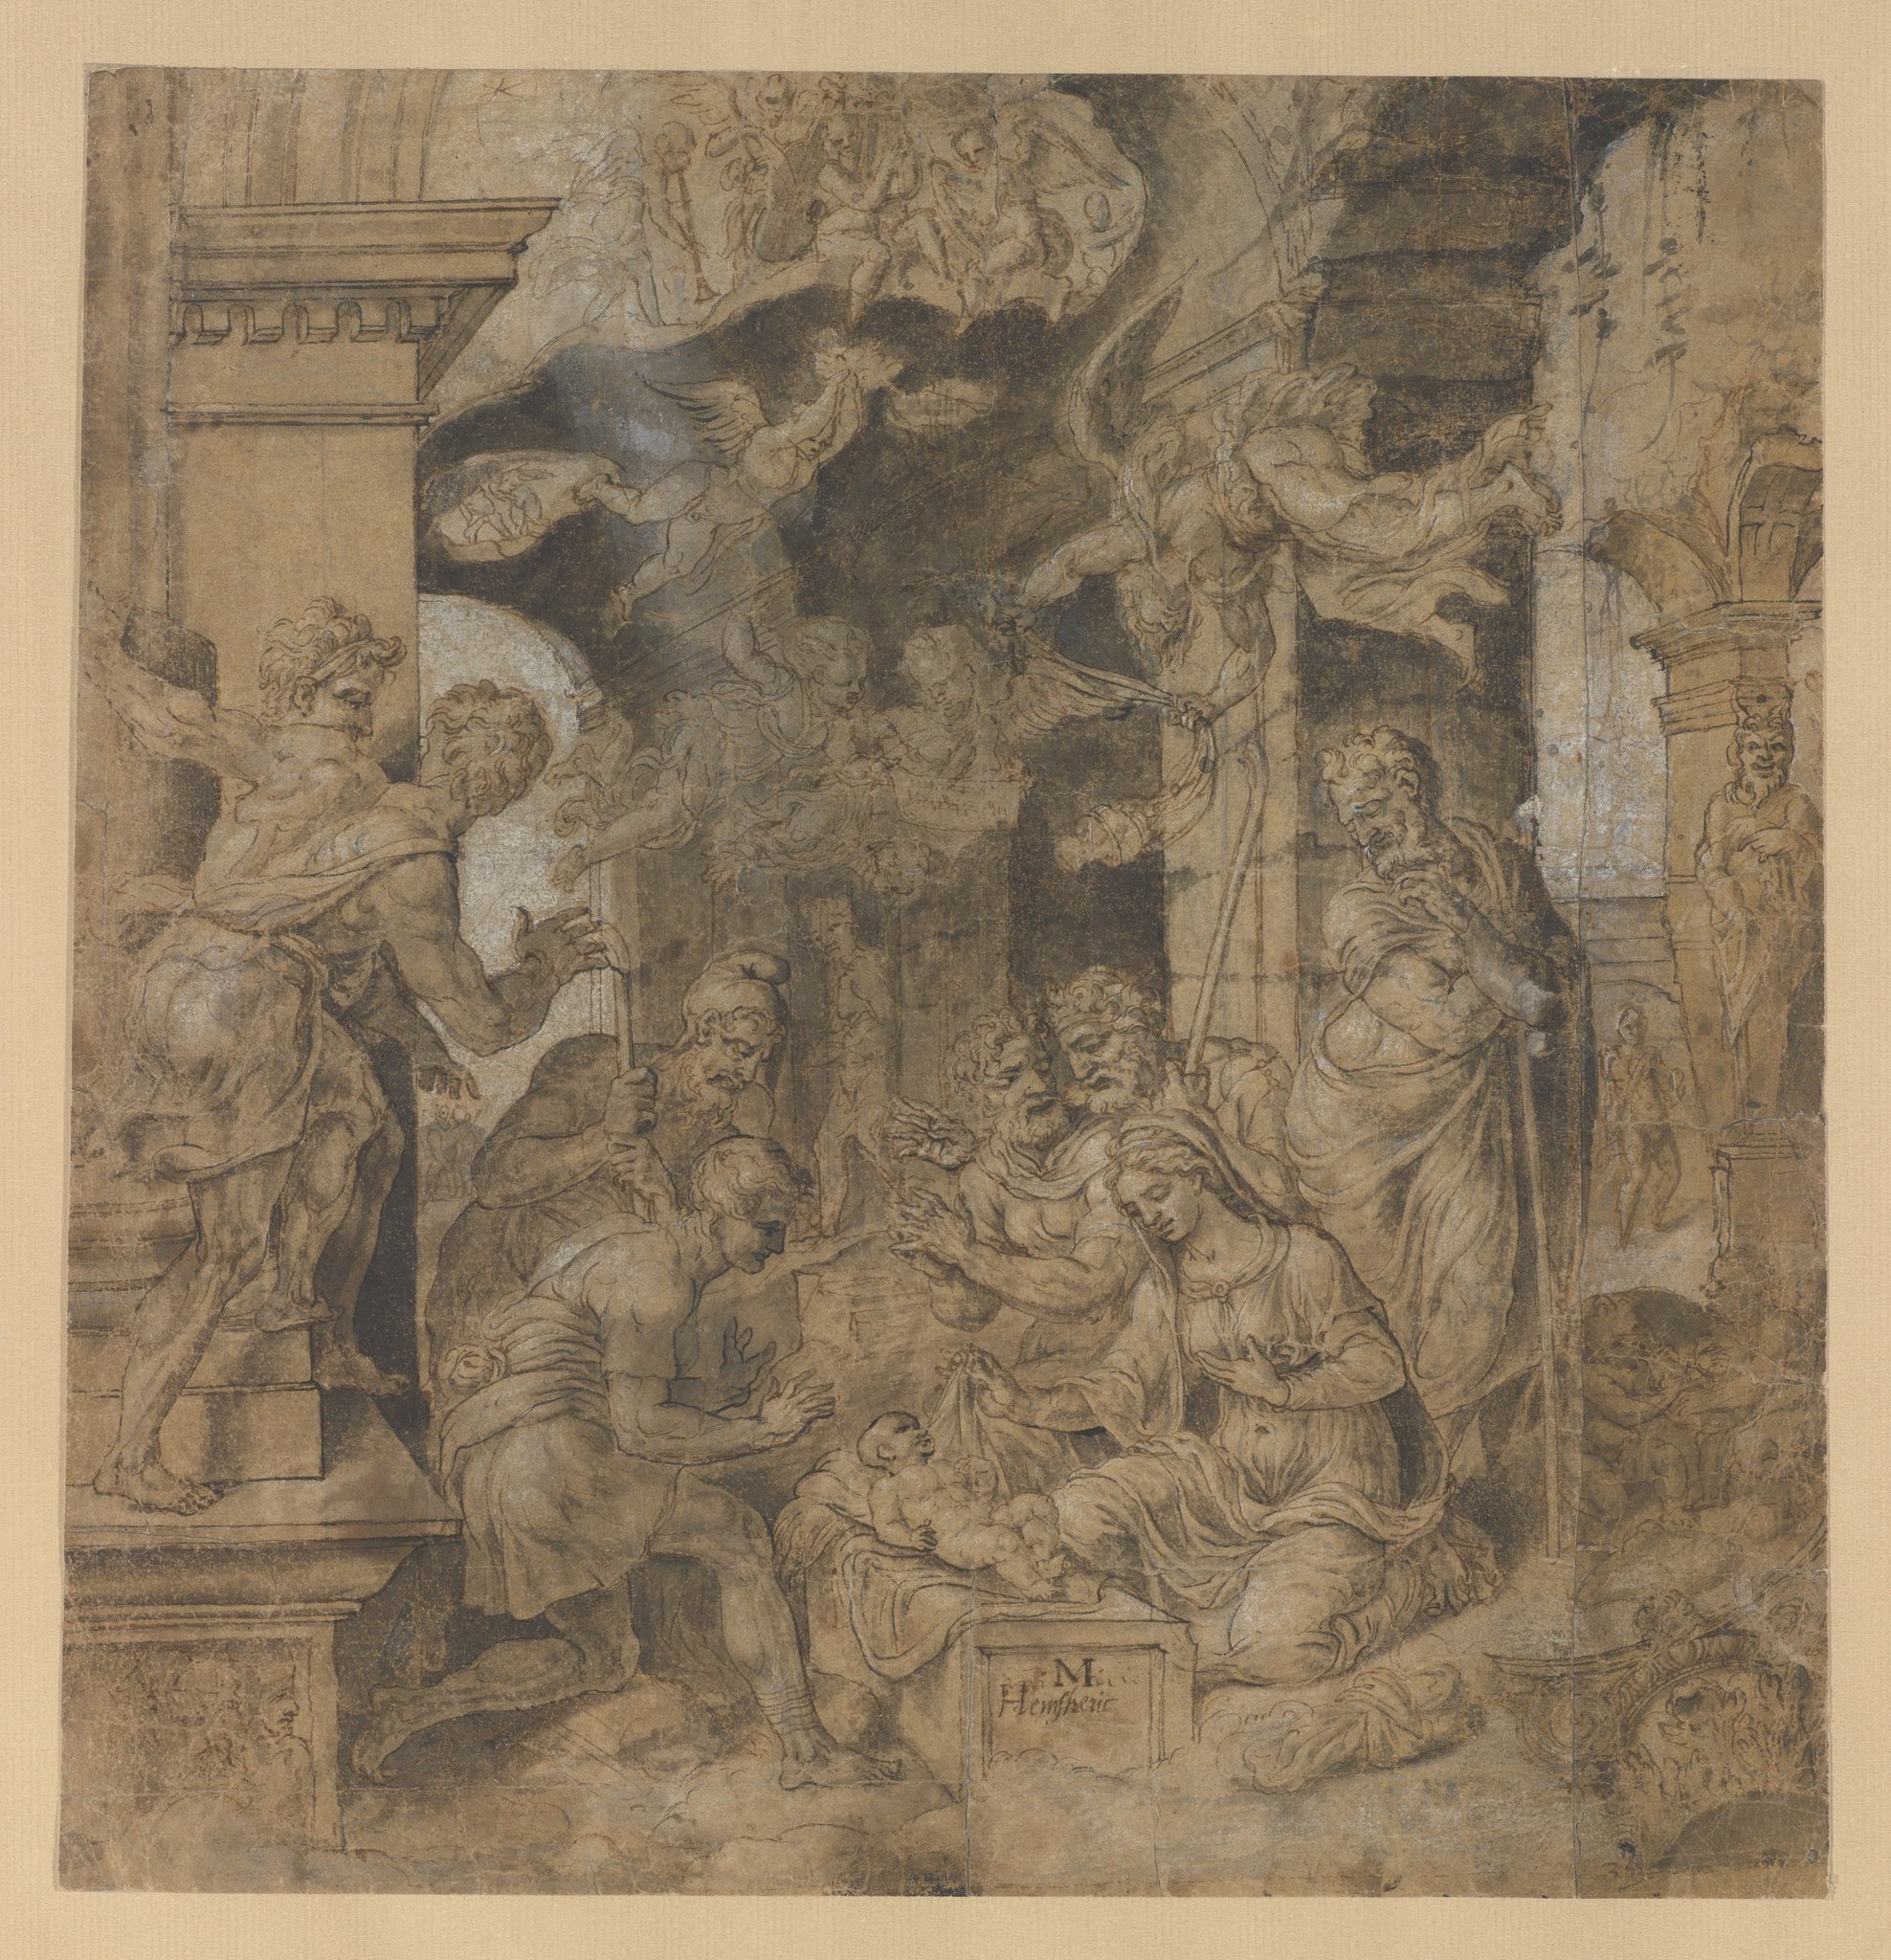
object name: drawing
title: The Adoration of the Shepherds (recto); Sketches (verso)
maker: maarten van heemskerck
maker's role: artist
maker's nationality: netherlandish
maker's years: 1498-1574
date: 1532-1537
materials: chalk, gouache, ink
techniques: brush, heightening, pen, wash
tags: adoration of the shepherds